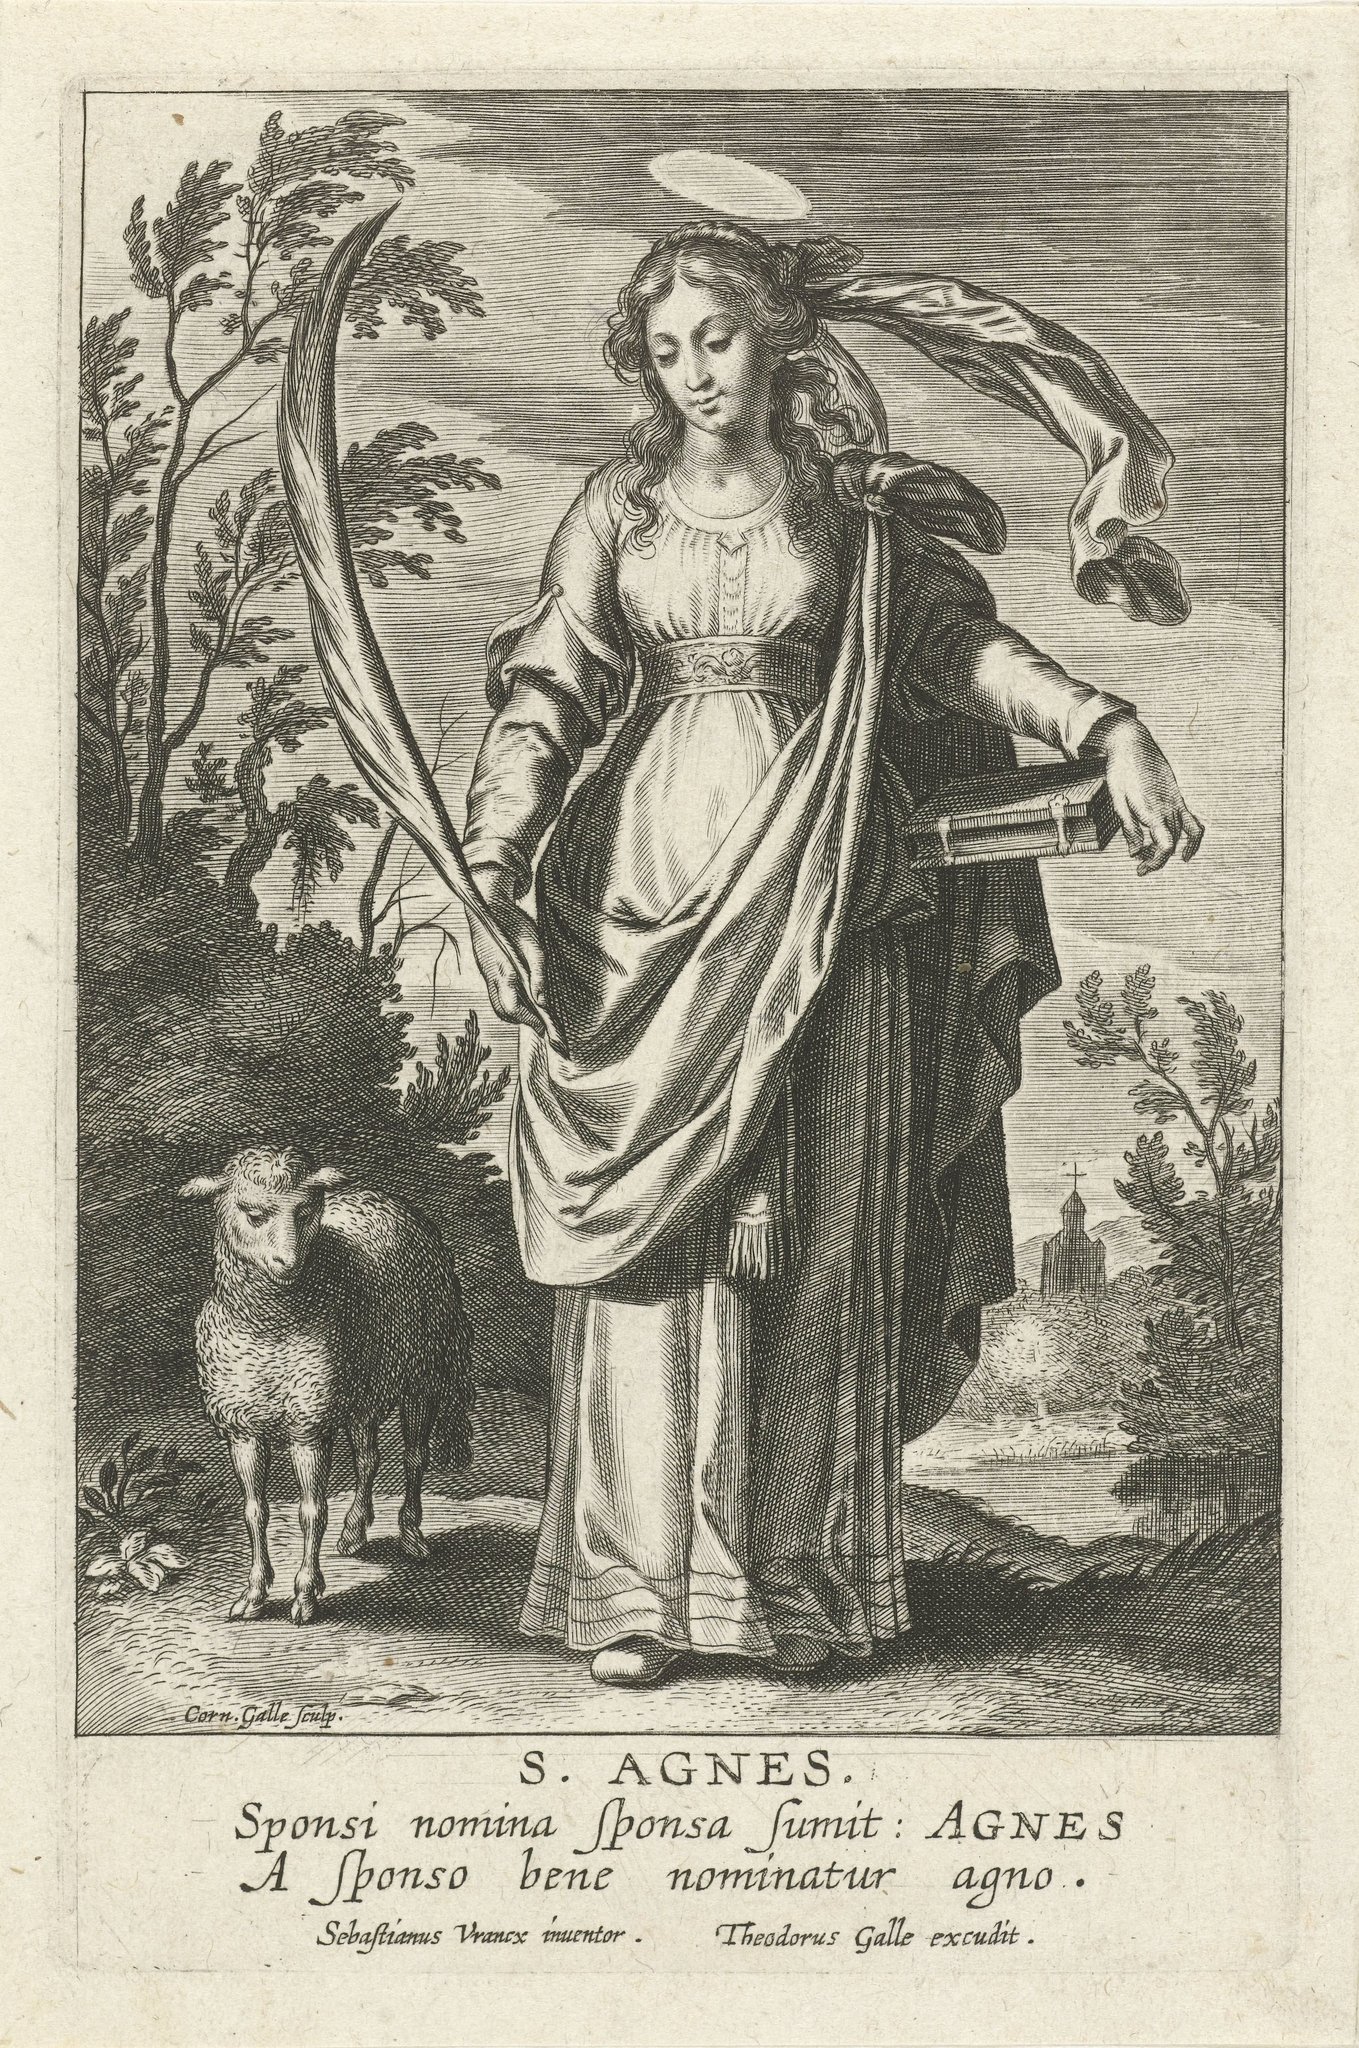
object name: print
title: Speculum Illustrium Virginum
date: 1596-1633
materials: paper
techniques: engraving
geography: antwerp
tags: the virgin martyr agnes of rome; possible attributes: lamb, ring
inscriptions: collector's mark: Lugt 2228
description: De heilige Agnes staande in een landschap, naast haar het lam. Agnes houdt een palmtak en een boek in haar handen. Onder de voorstelling een Latijns vers op Agnes. Waarschijnlijk deel van een serie van vrouwelijke heiligen uitgegeven door Theodoor Galle.